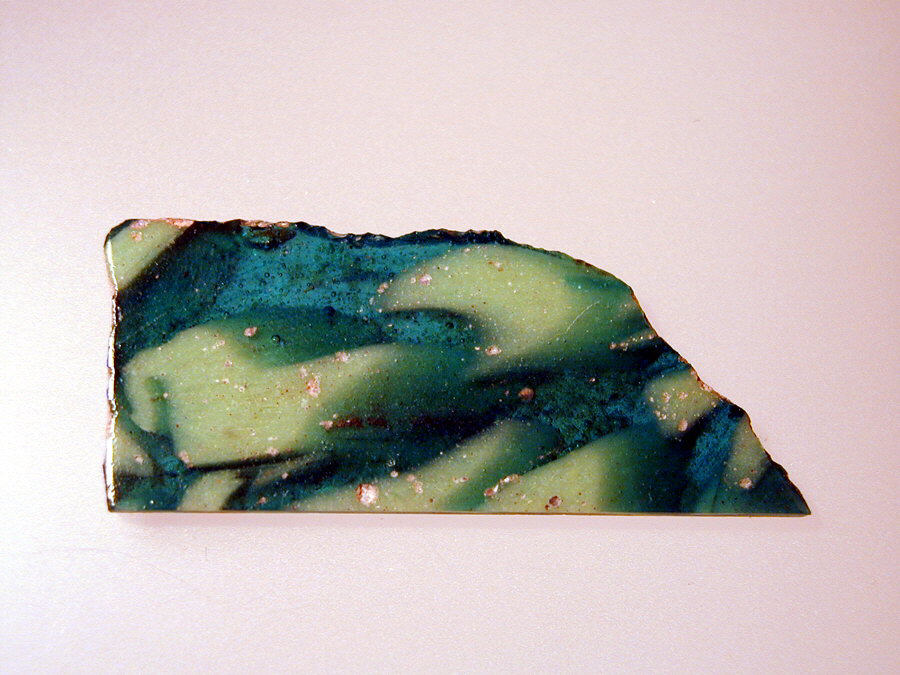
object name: fragment, mosaic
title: Glass mosaic inlay fragment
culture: roman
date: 34 BCE-33 CE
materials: glass